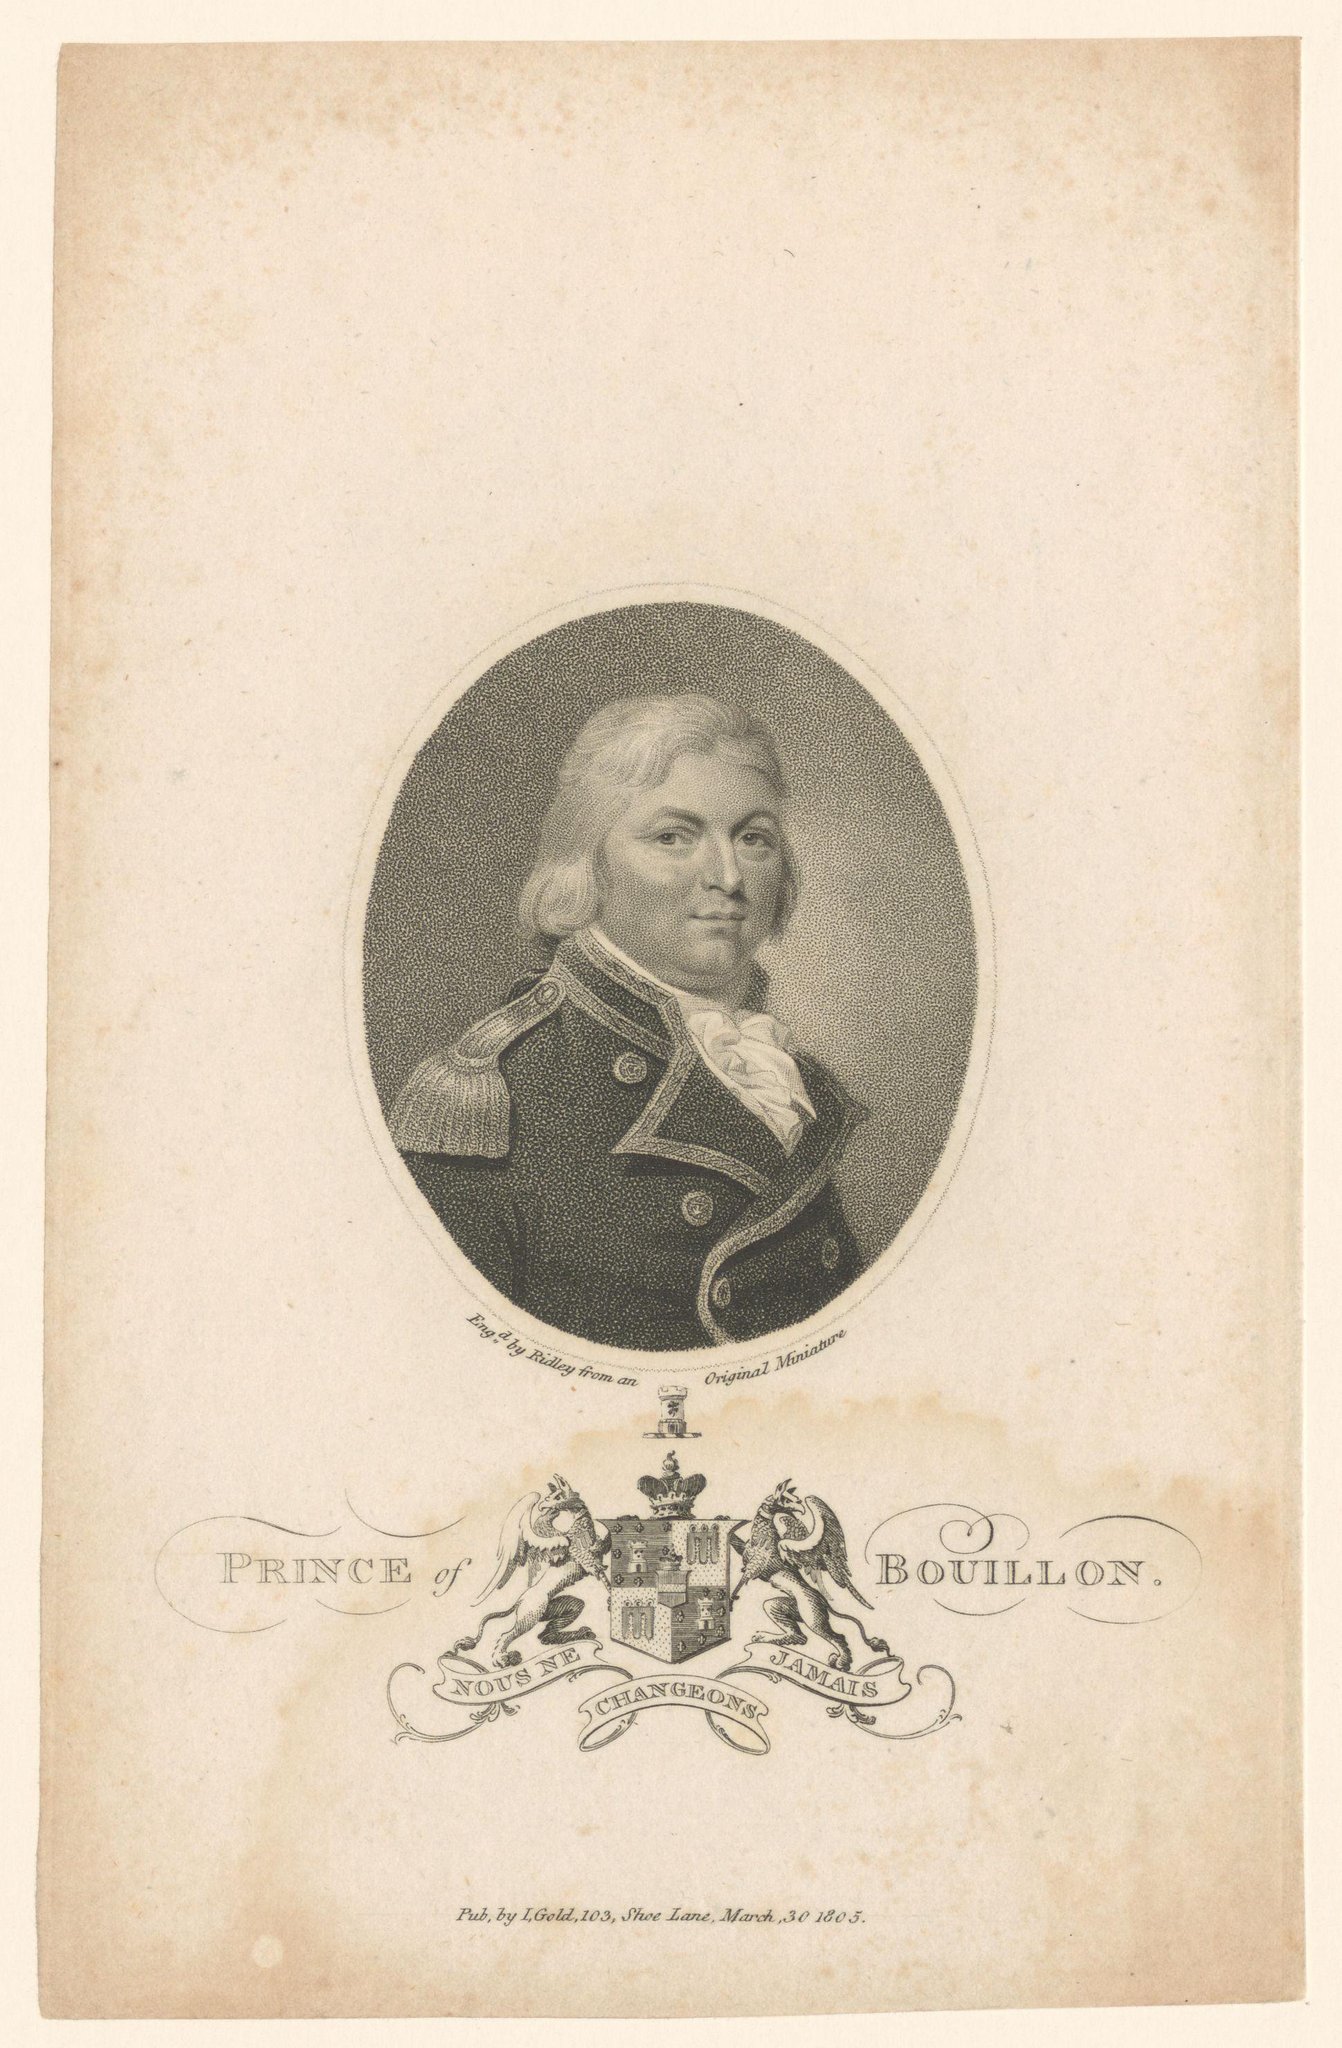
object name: print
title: Prince of Bouillon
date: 1805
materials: paper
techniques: stippling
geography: london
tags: london, historical persons, commander-in-chief, admiral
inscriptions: collector's mark: Lugt 2228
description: Wapenschild met tekst in het Frans in de ondermarge.